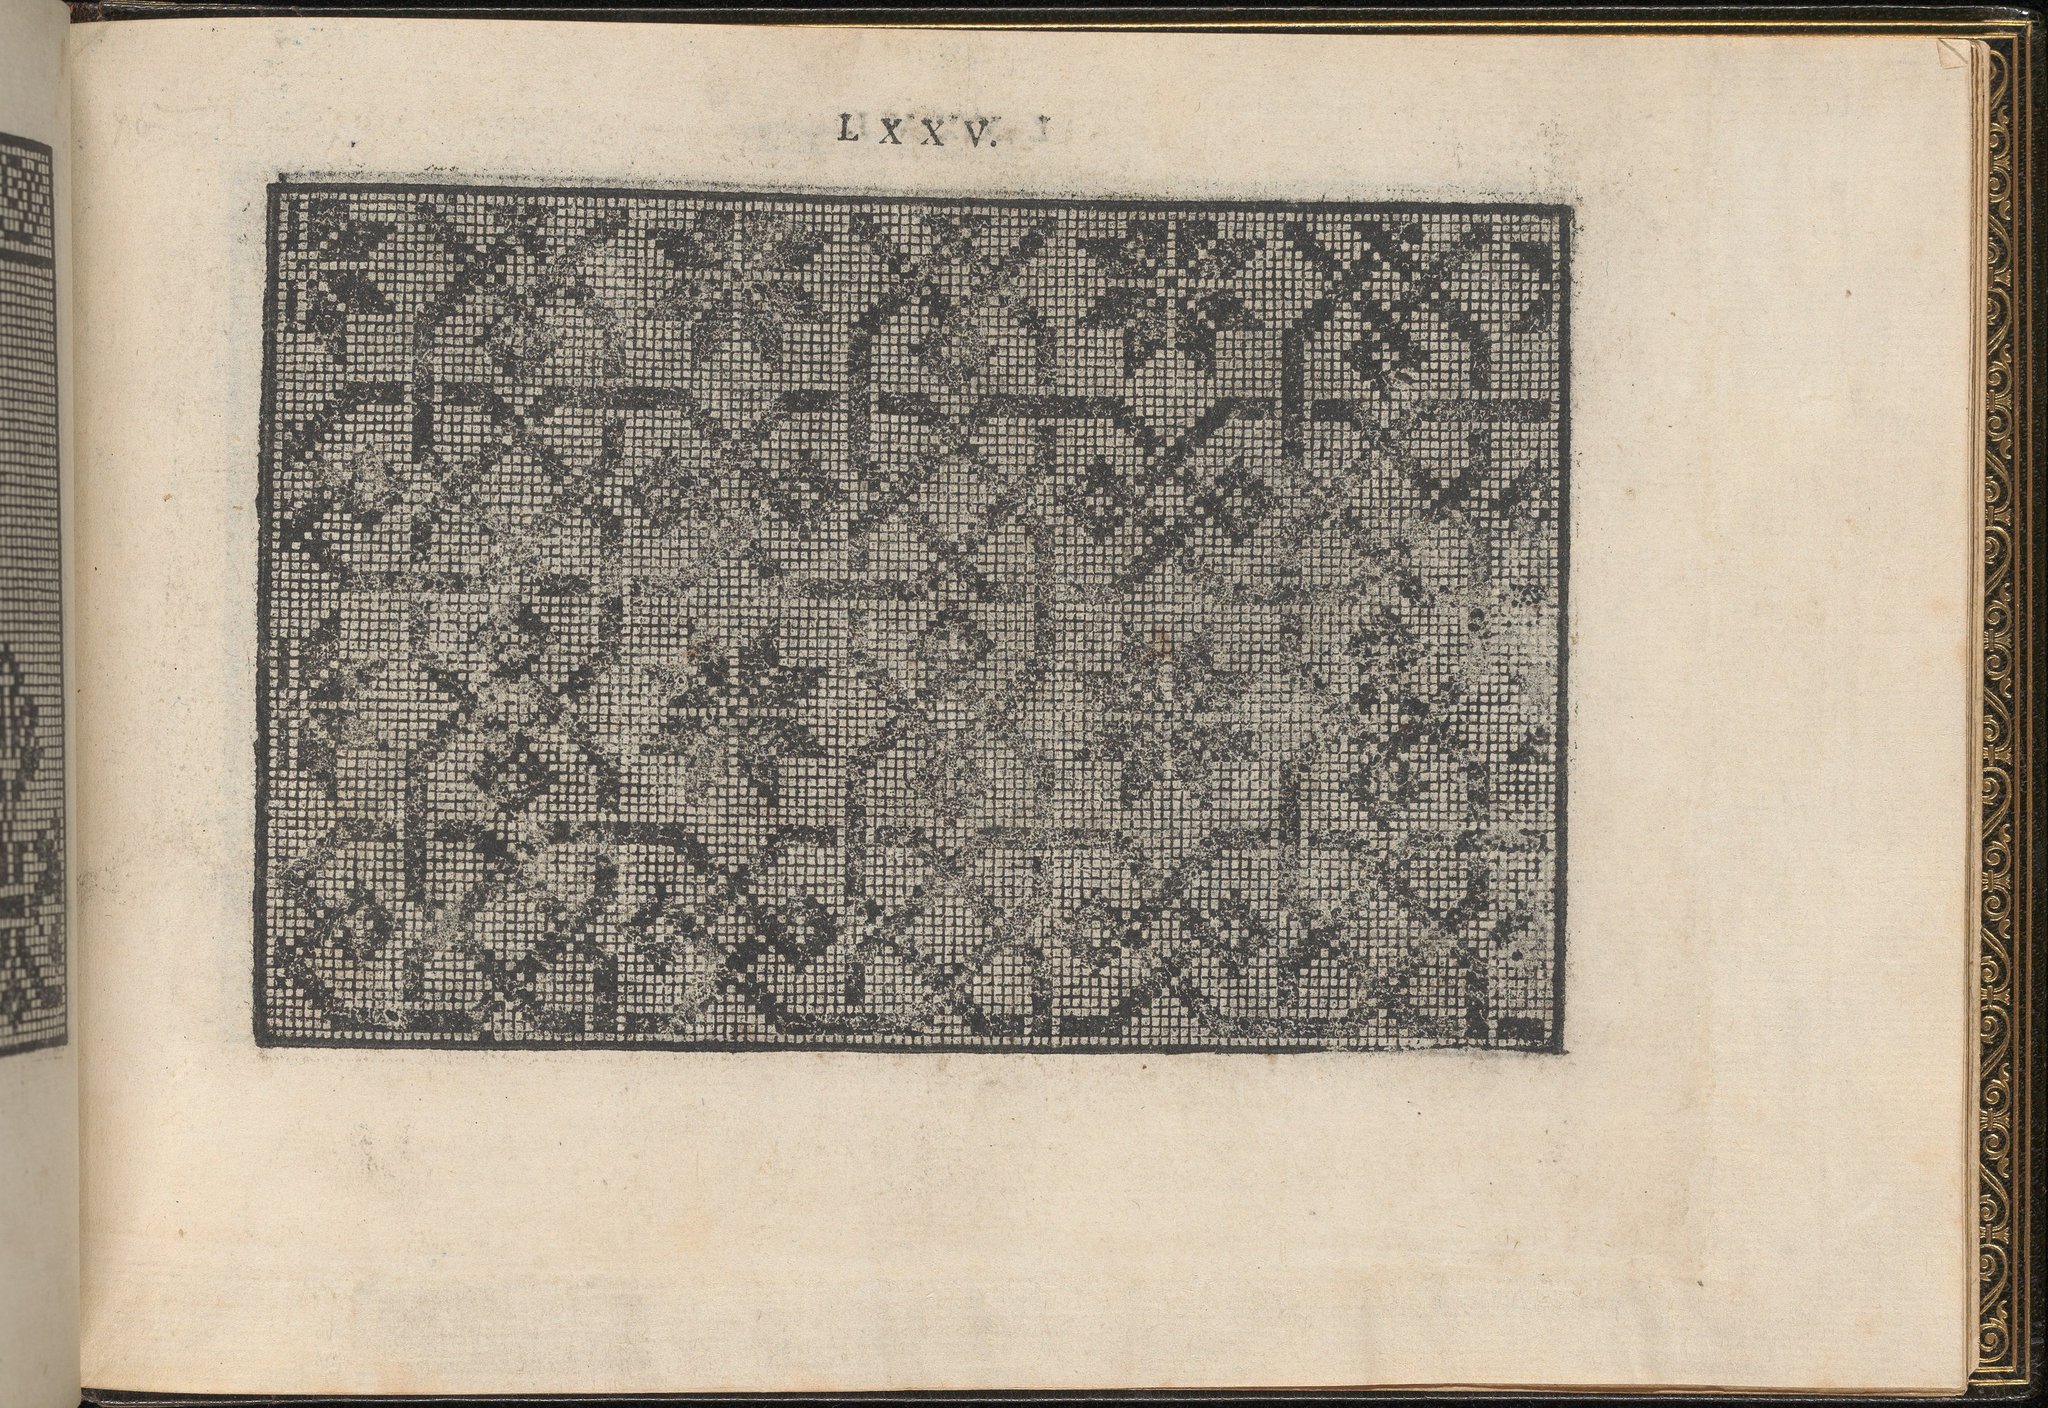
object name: book print ornament architecture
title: La Vera Perfettione del Disegno di varie sorti di recami, page 38 (recto)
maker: giovanni ostaus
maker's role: publisher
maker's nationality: italian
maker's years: 1507-1607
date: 1567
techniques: woodcut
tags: ornament